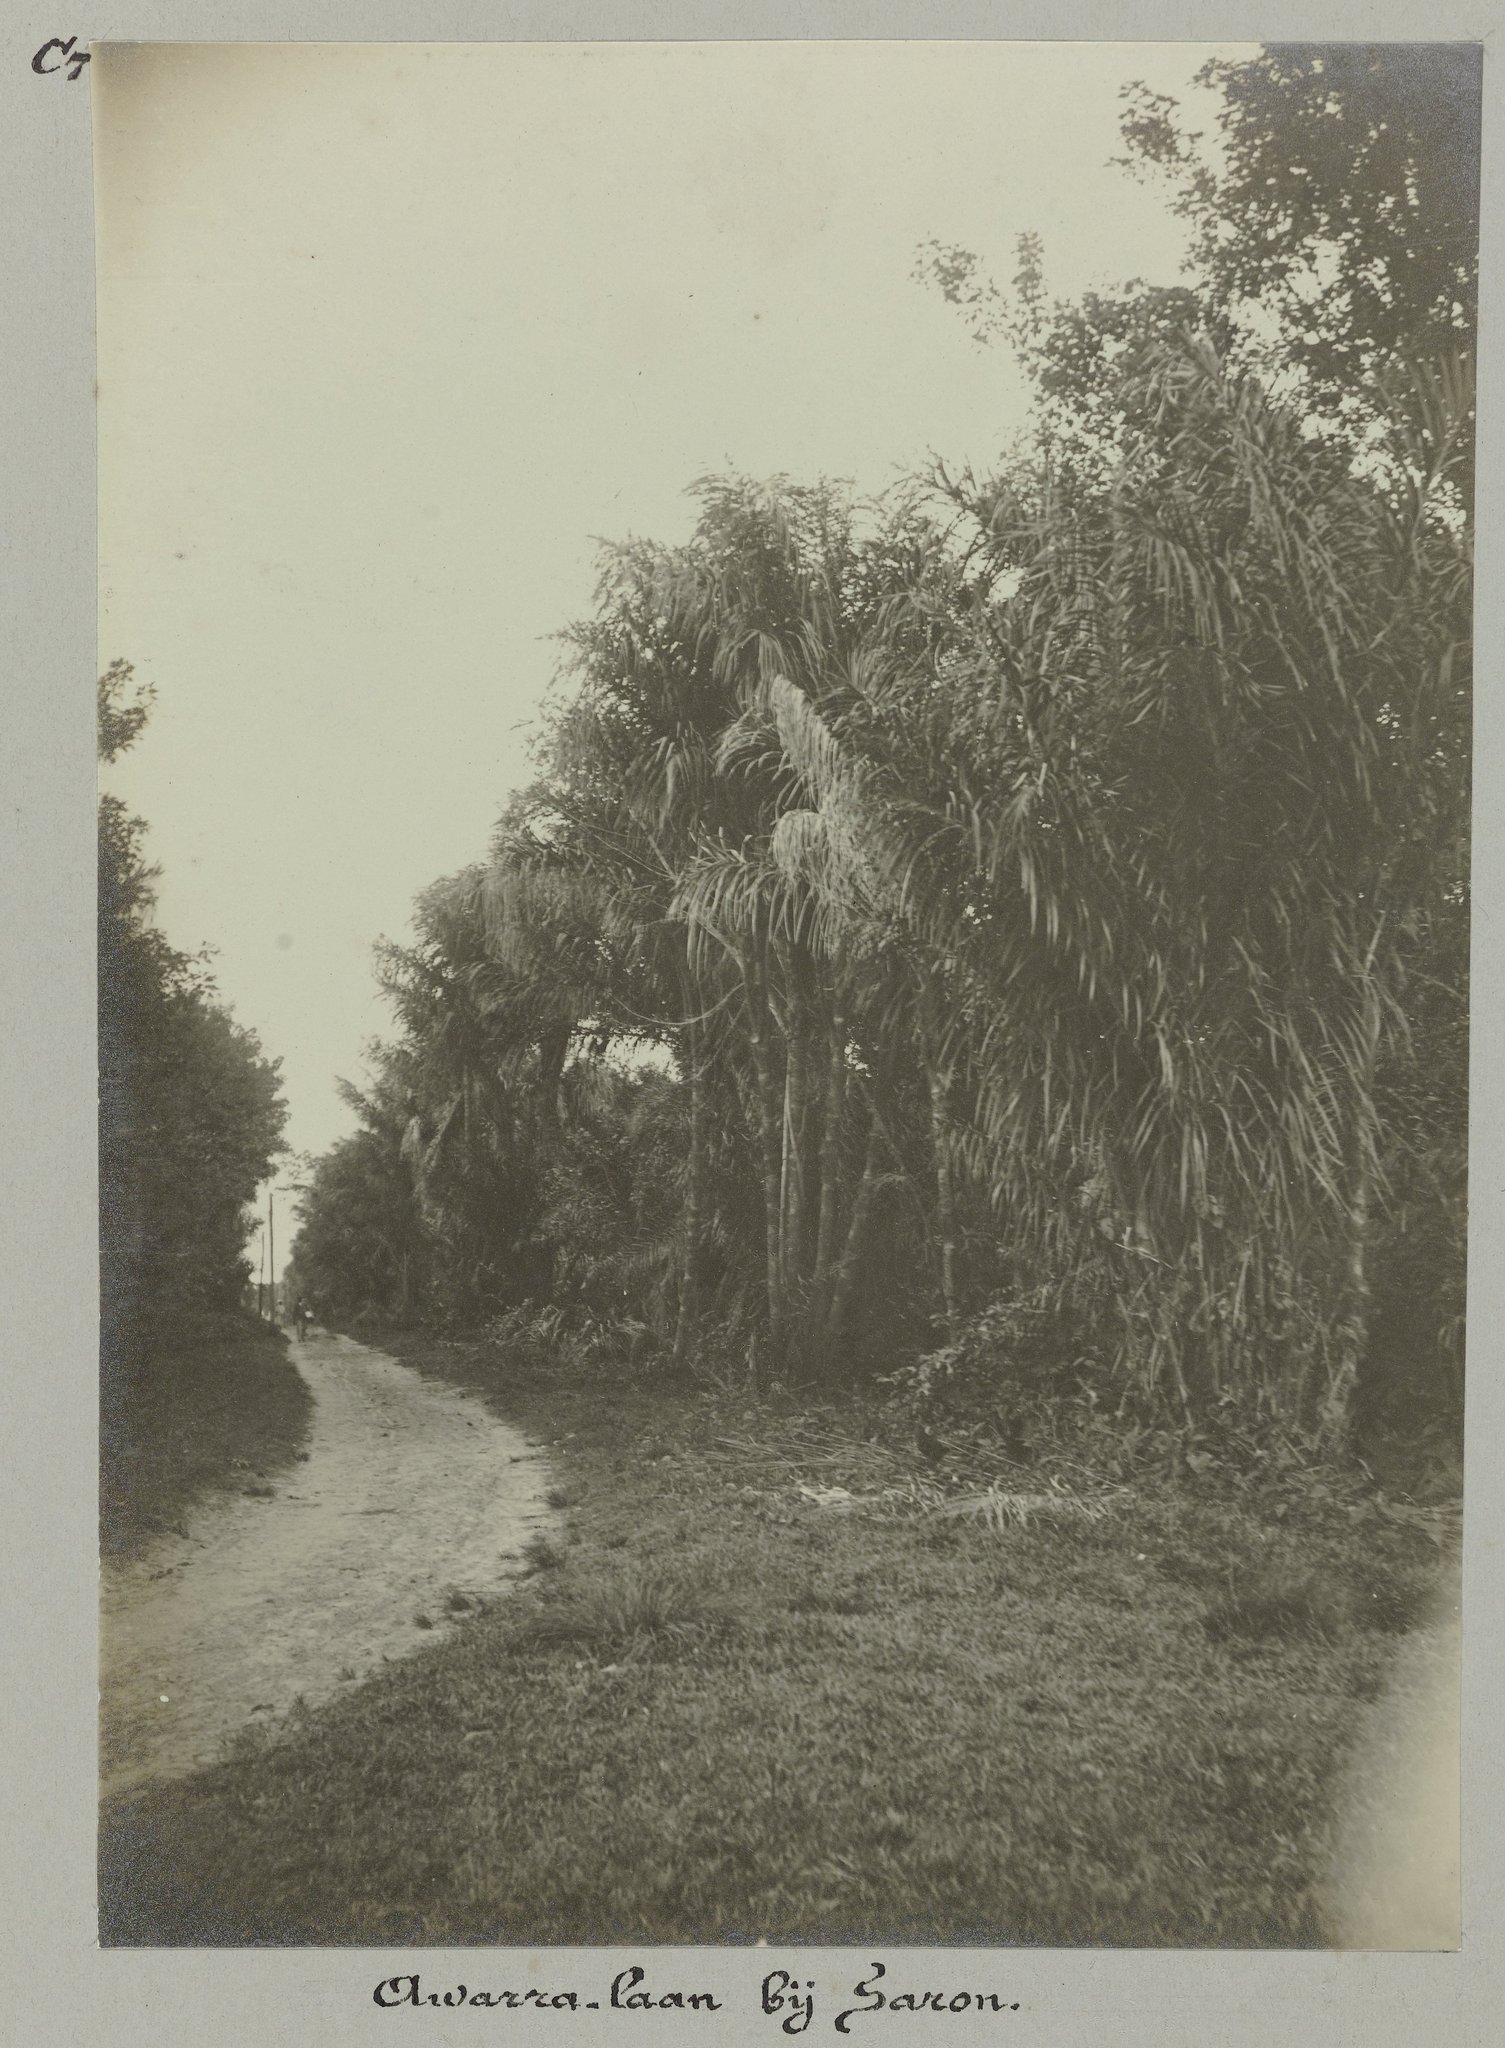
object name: photograph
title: Awarra-laan bij Saron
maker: hendrik doijer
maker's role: engineer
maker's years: 1863-1925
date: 1903-1910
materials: photographic support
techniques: gelatin silver print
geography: suriname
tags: suriname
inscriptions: inscription: ‘C7 / Awarra-laan bij Saron.’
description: Gezicht op de Awarralaan bij Saron, onverharde weg langs hoge bamboe. Onderdeel van het fotoalbum Souvenir de Voyage (deel 2), over het leven van de familie Doijer in en rond de plantage Ma Retraite in Suriname in de jaren 1903-1910.